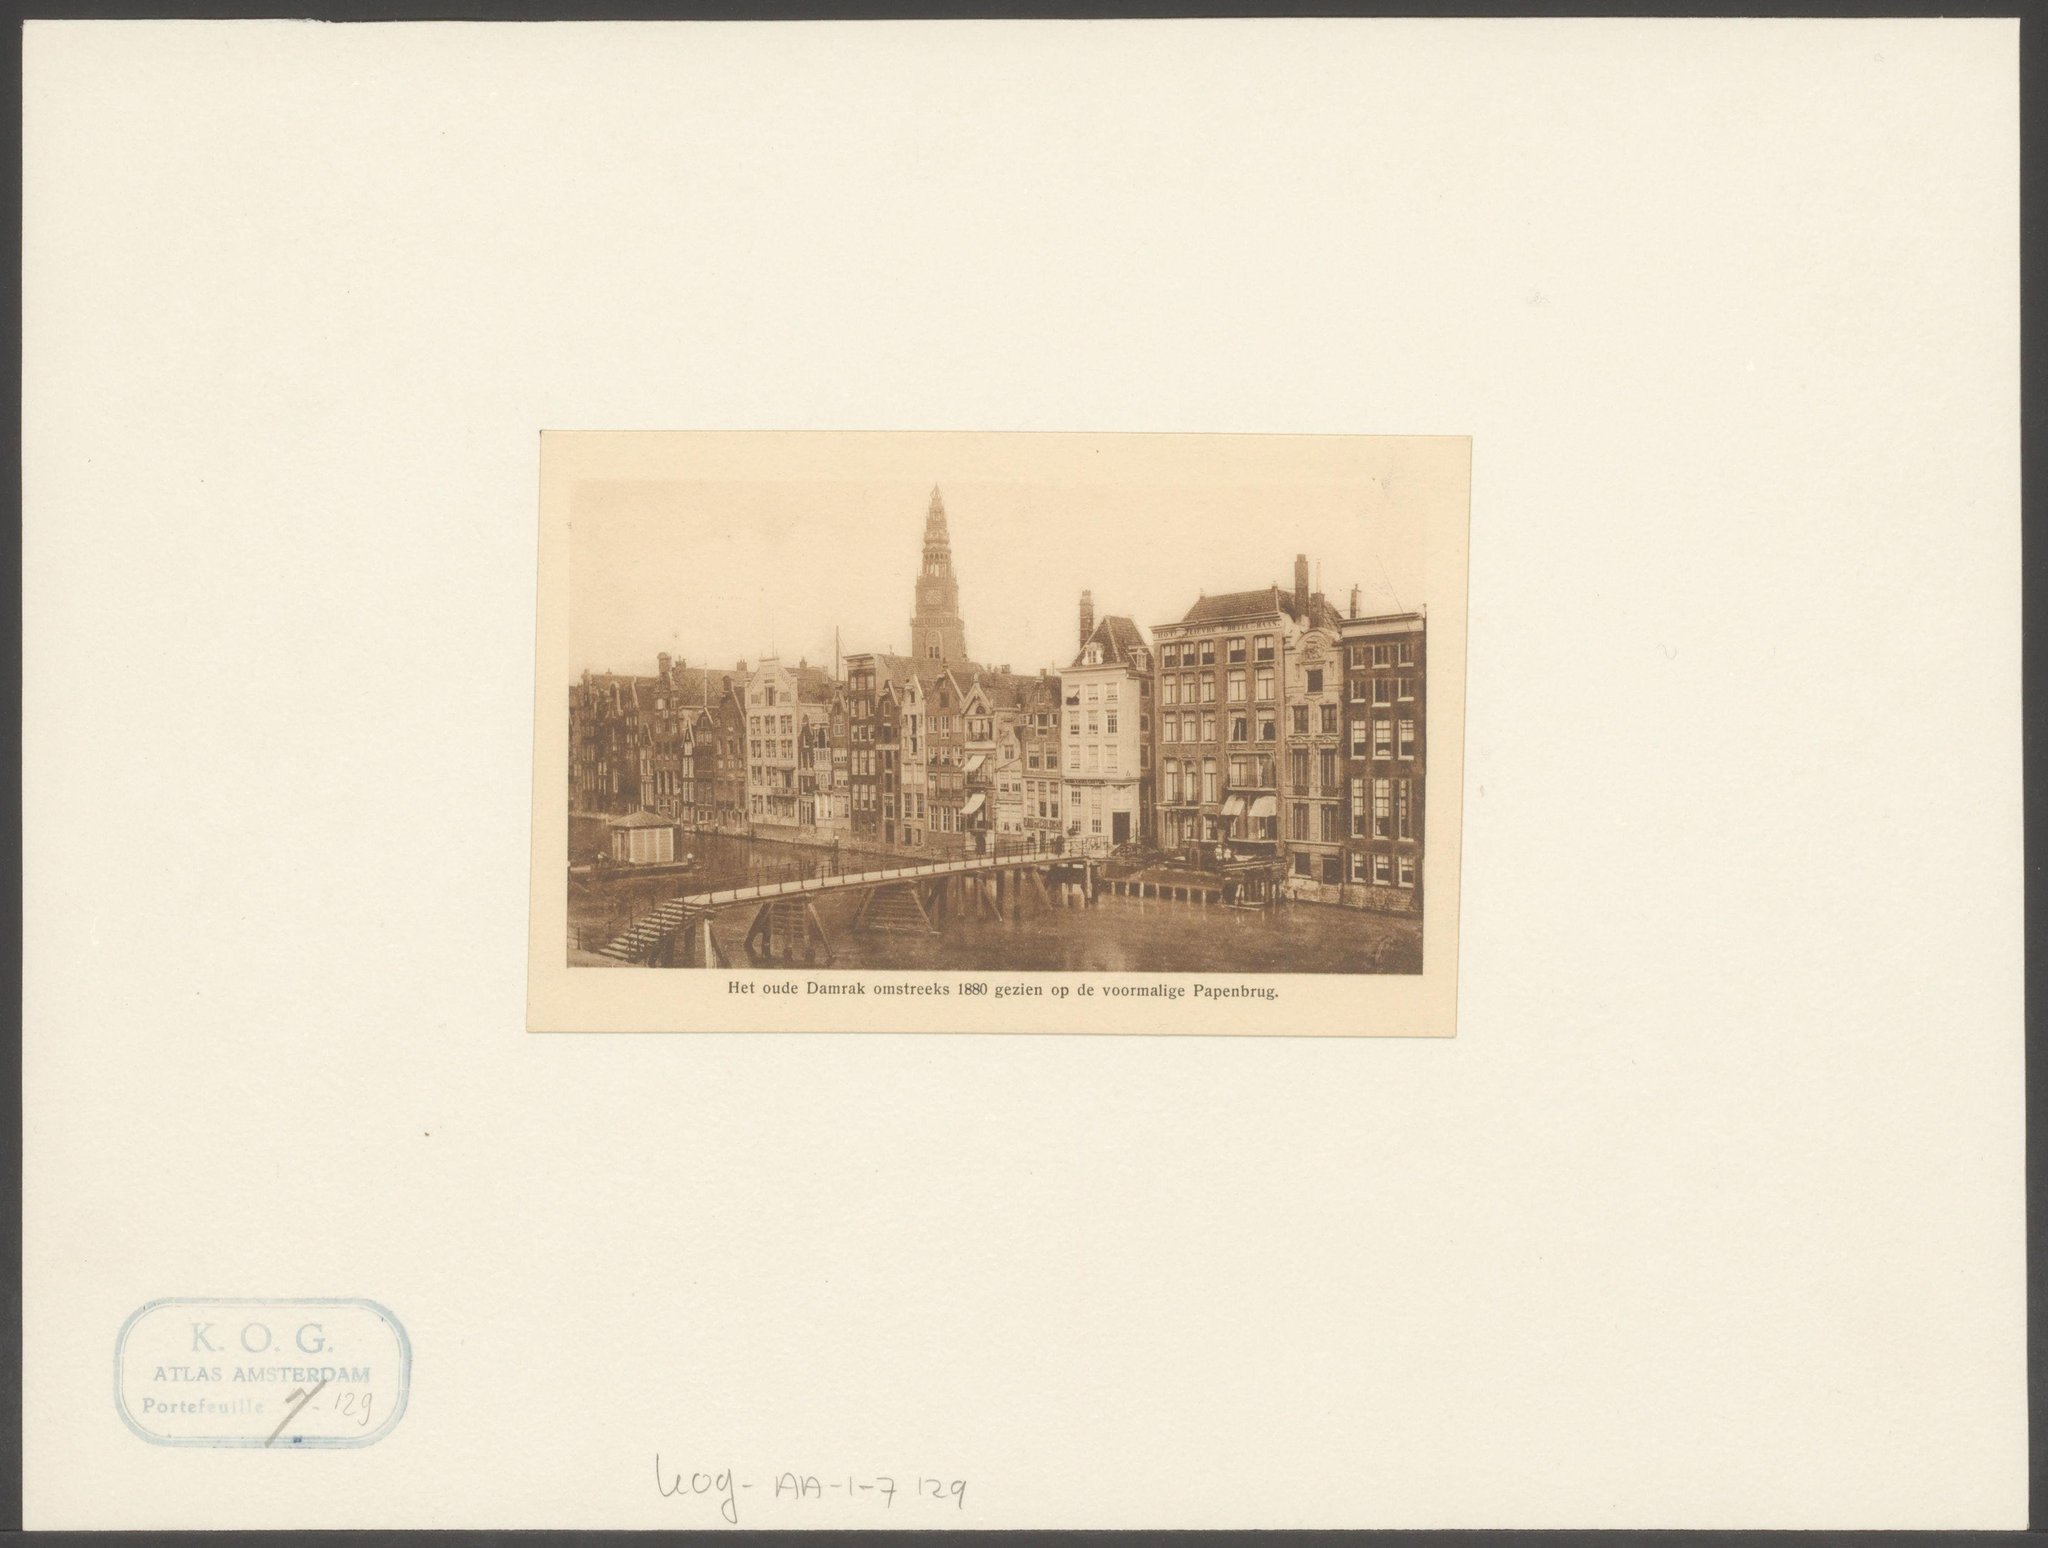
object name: photomechanical print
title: Gezicht op het Damrak, gezien op de Papenbrug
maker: Anonymous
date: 1880-1930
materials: paper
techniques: photograph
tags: city-view in general; 'veduta', canal, bridge in city across river, canal, etc.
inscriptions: collector's mark: ‘4’ Lugt 1641b, collector's mark: ‘7’ Lugt 1641b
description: Onderwerpsrubriek binnen de Atlas Amsterdam: Damrak, Damstraat, Doelensluis, Doelenstraat (Nieuwe), Driehoekstraat, Droogbak, Duvelshoek, Dijkstraat en Korte -.